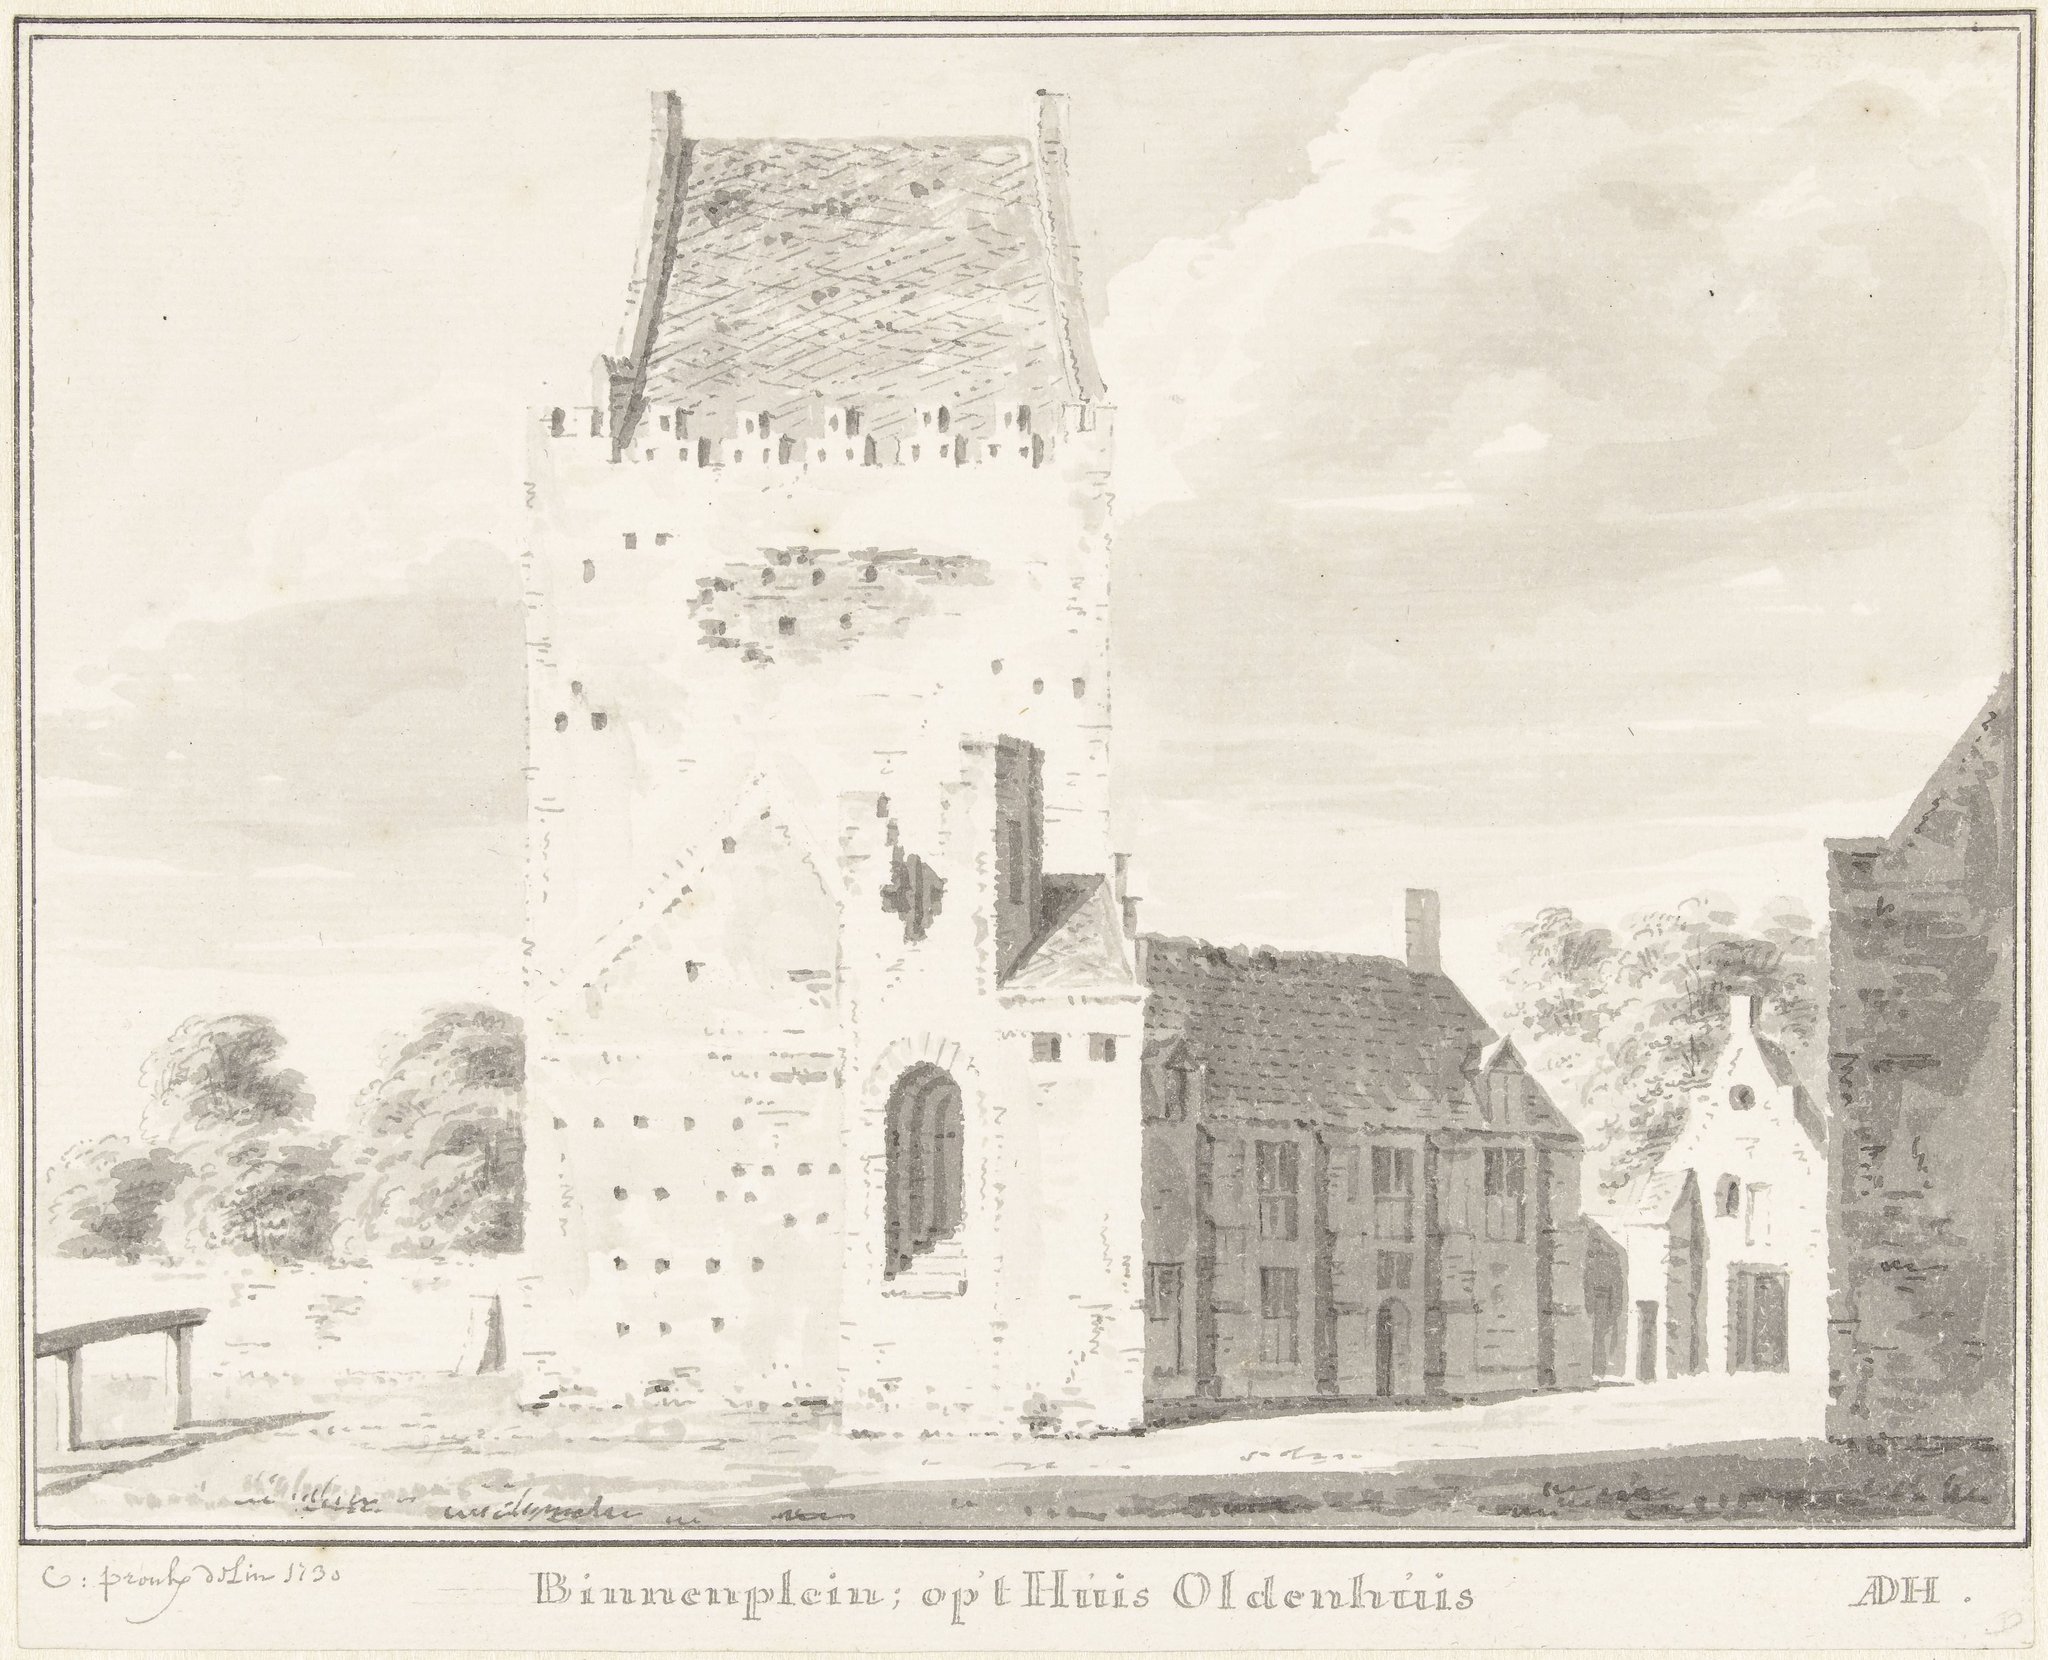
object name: drawing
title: Binnenplein van het Huis Oldenhuis te Vollenhove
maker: cornelis pronk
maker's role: draughtsman, painter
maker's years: 1691-1759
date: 1730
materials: ink, paper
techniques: brush, pen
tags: castle